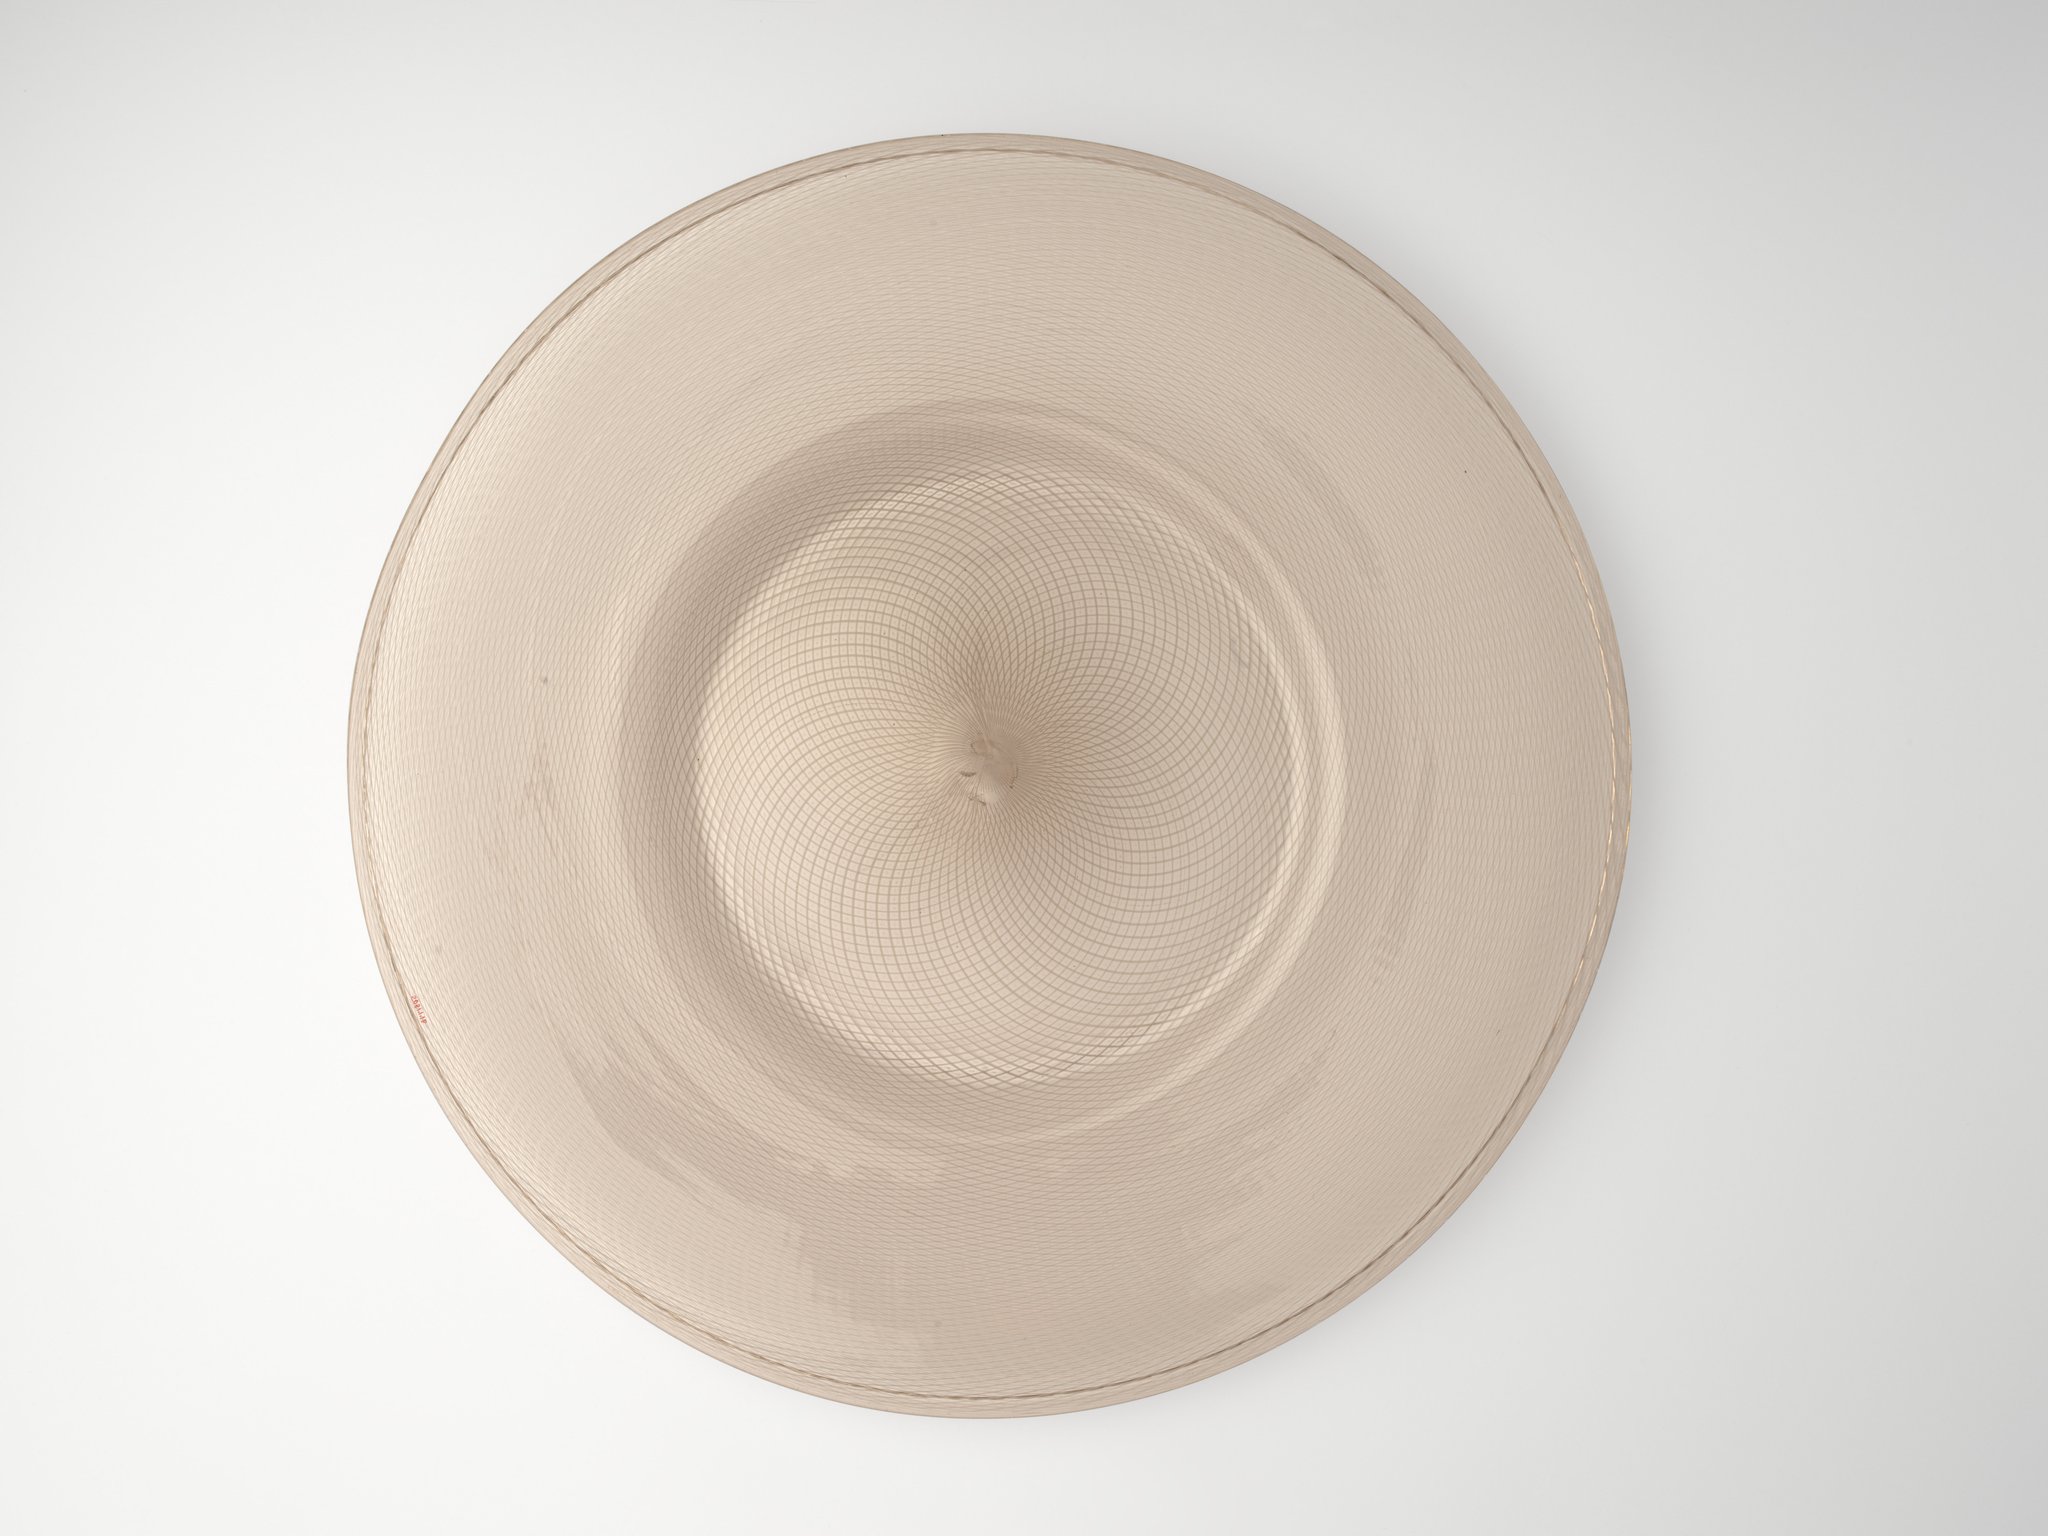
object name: plate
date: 1601-1733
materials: glass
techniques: glassblowing